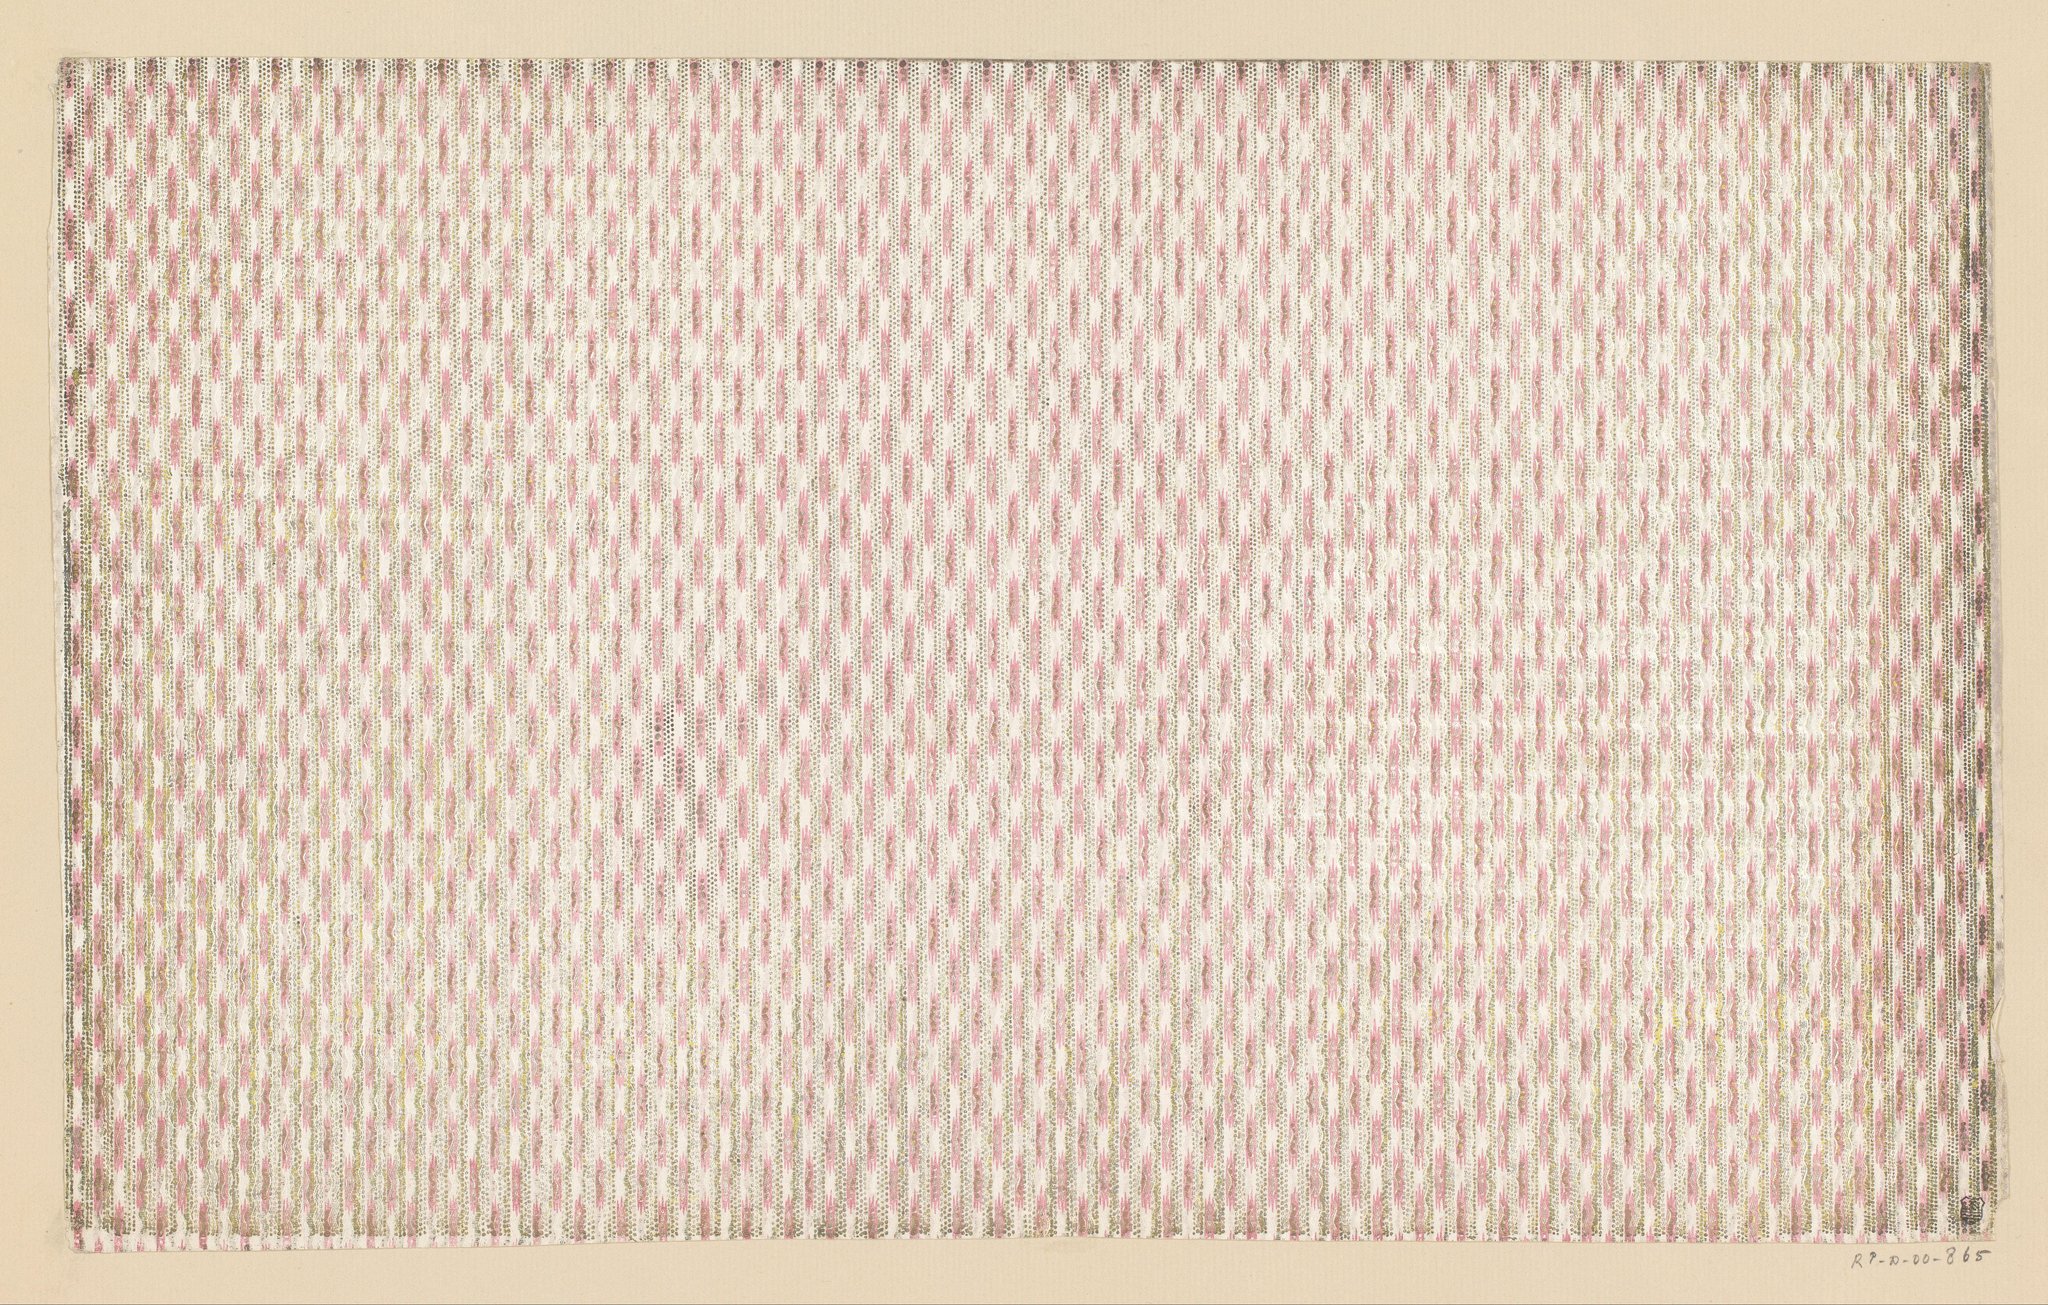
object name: embossed paper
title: Blad met gegaufreerde verticale golvende banen van horizontale streepjes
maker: Anonymous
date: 1800-1900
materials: paint, paper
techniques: machining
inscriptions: collector's mark: Lugt 2760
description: Blad met gegaufreerde verticale golvende banen van horizontale streepjes met daaroverheen een verticaal streepmotief tussen stippen.